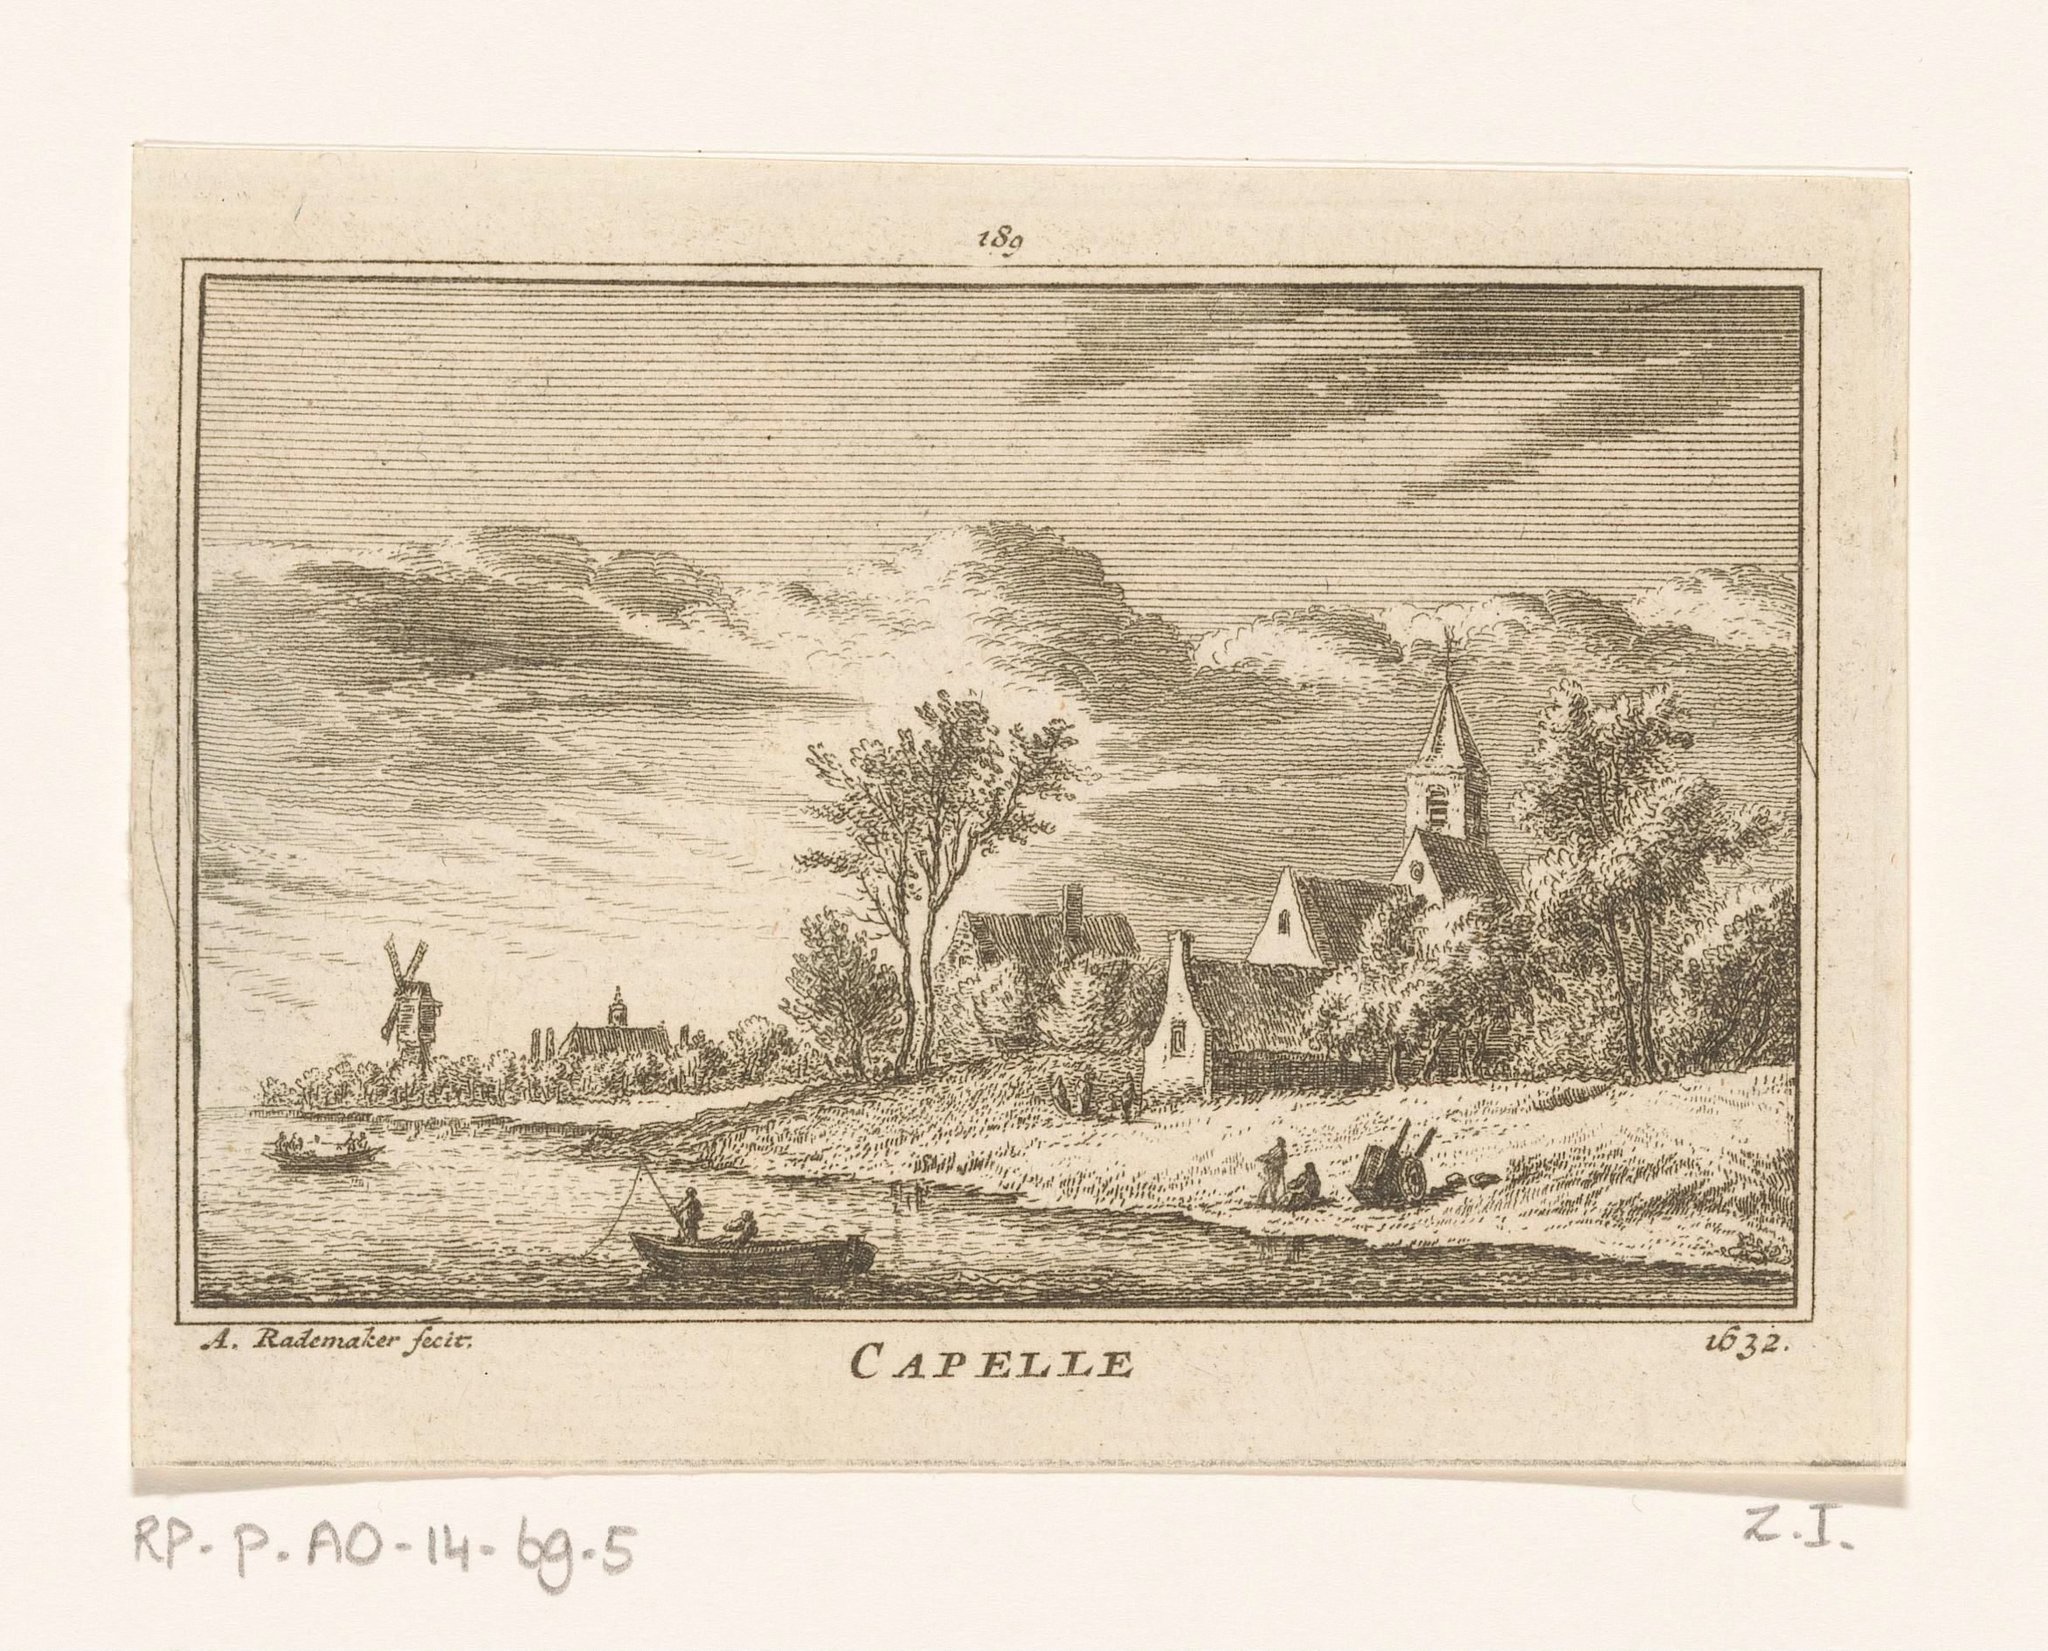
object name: book illustration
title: Capelle 1632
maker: abraham rademaker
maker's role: draughtsman, print maker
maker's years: 1676-1735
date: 1725-1803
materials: paper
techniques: engraving, etching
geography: amsterdam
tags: prospect of village, silhouette of village, church (exterior), rowing-boat, canoe, etc., windmill, fisherman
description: Prent ook gebruikt in: Rademaker, Abraham. Kabinet van Nederlandsche outheden en gezichten: vervat in 300 konstplaaten (…). 2 delen. Amsterdam: Willem Barents, 1725, dl. 2, ill. 189. Na 1725 is deze prent nog in verschillende heruitgaven verschenen, uitgegeven in 1727-1733, 1770-1771 en 1792-1803. Uit welke uitgave het huidige exemplaar precies komt is niet na te gaan.